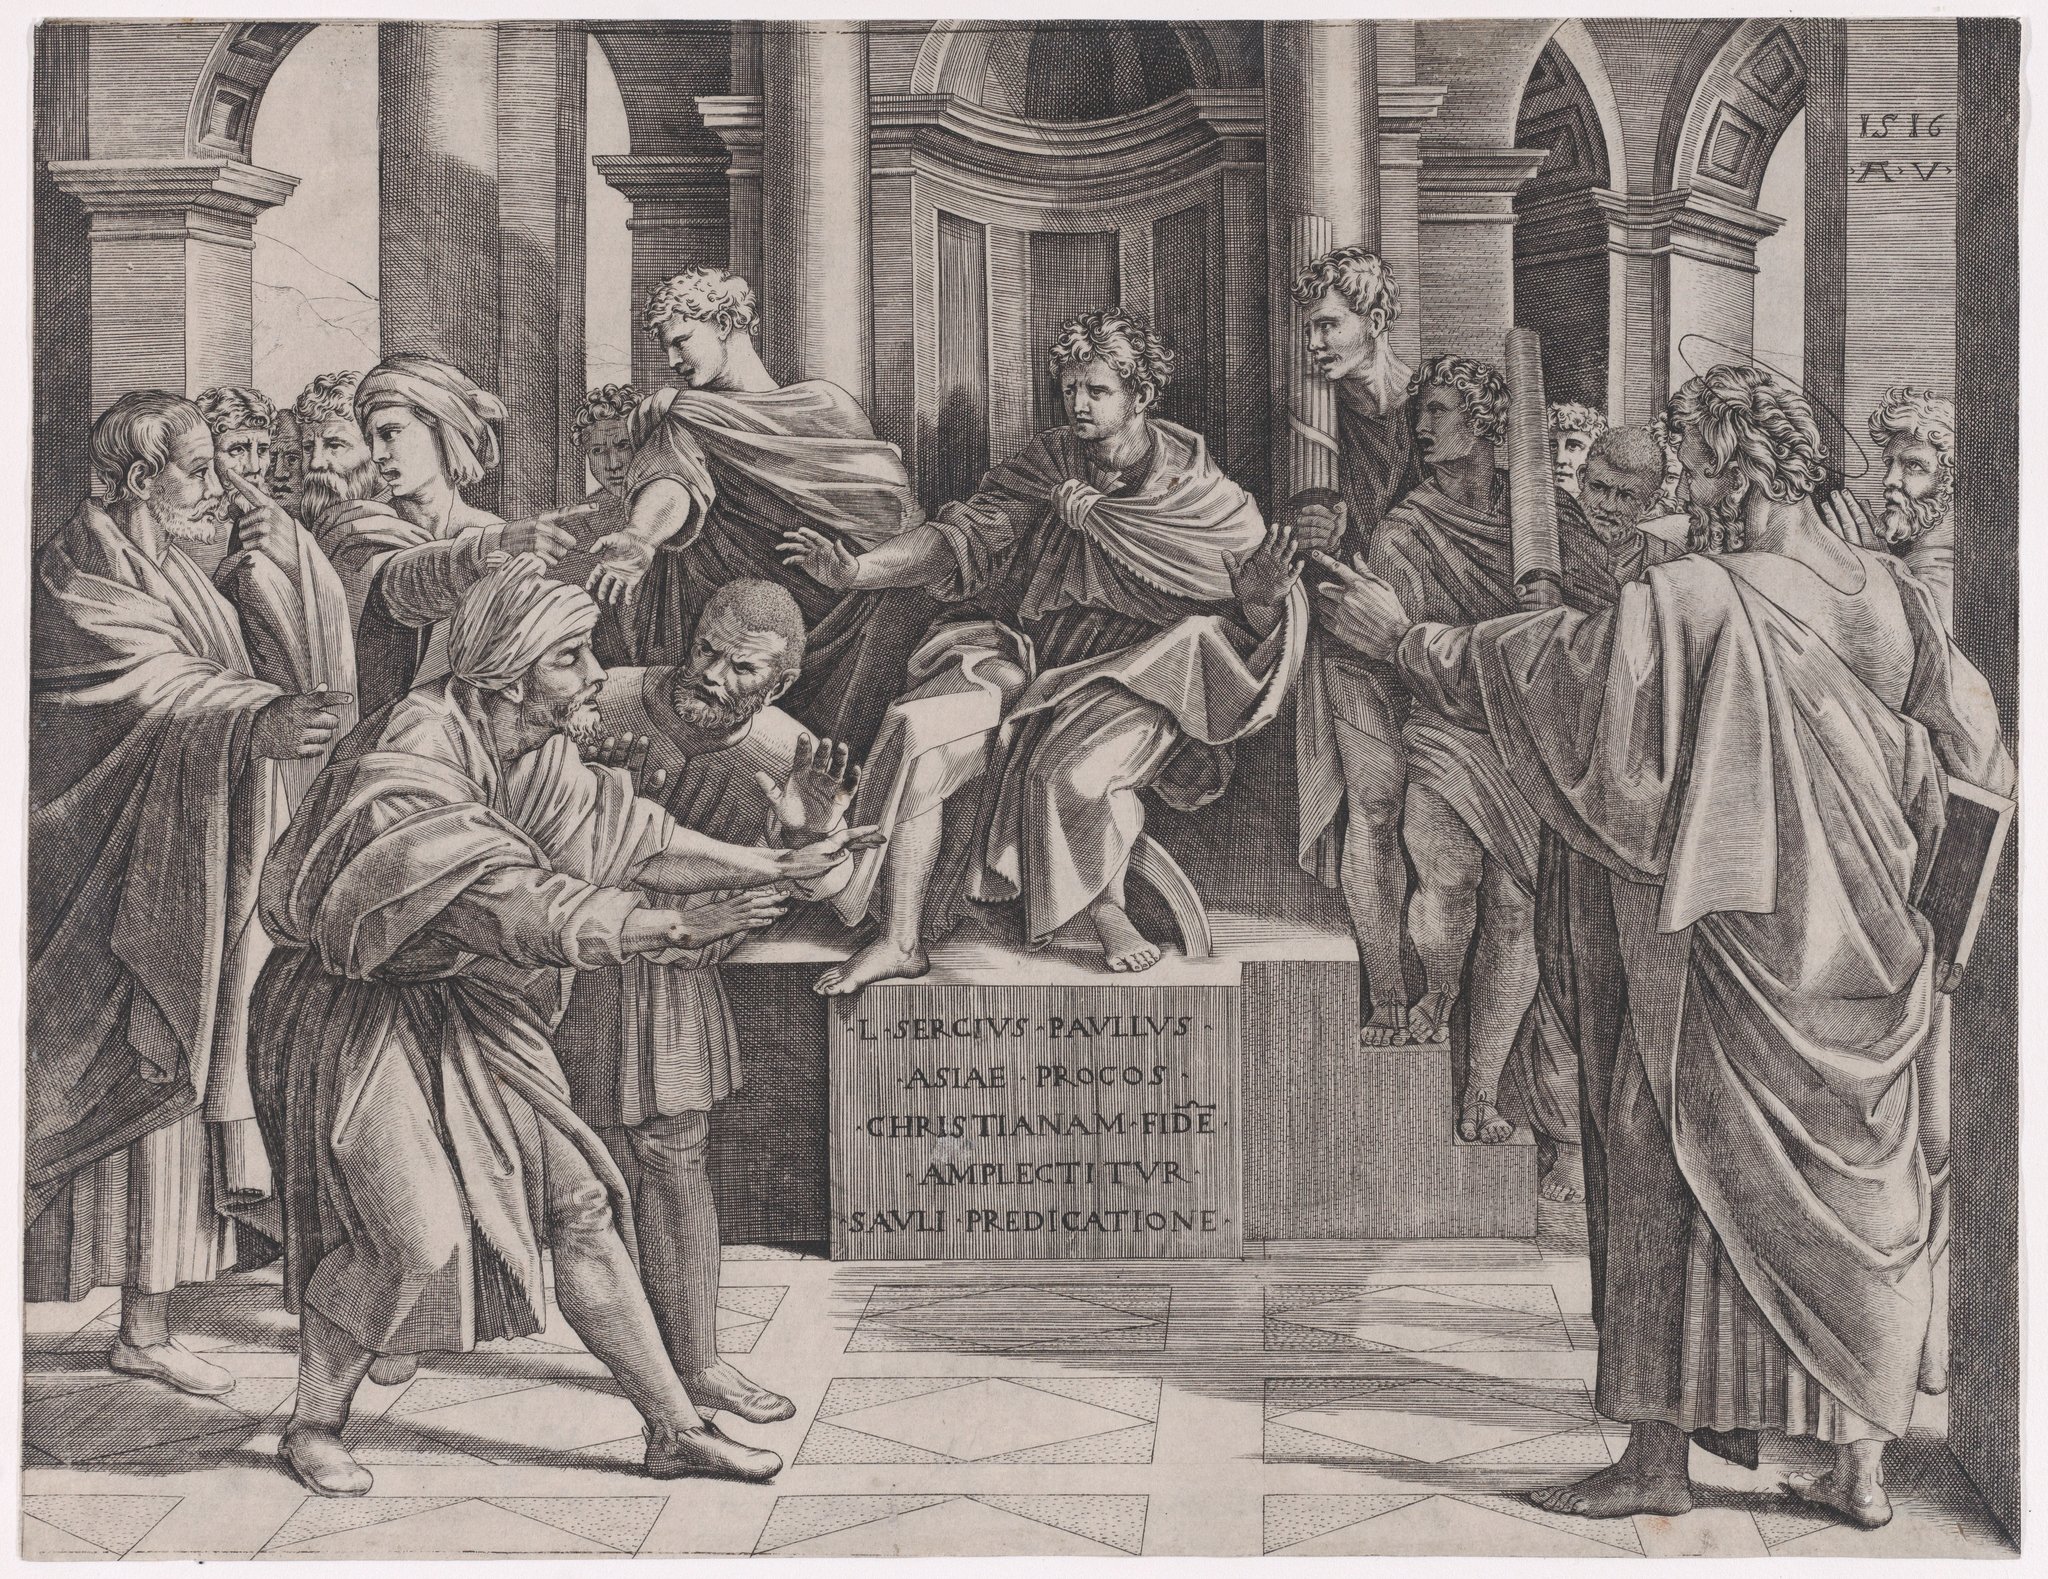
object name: print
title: The Blinding of Elymas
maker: agostino veneziano (agostino dei musi)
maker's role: artist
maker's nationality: italian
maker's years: 1490-1536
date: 1516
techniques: engraving